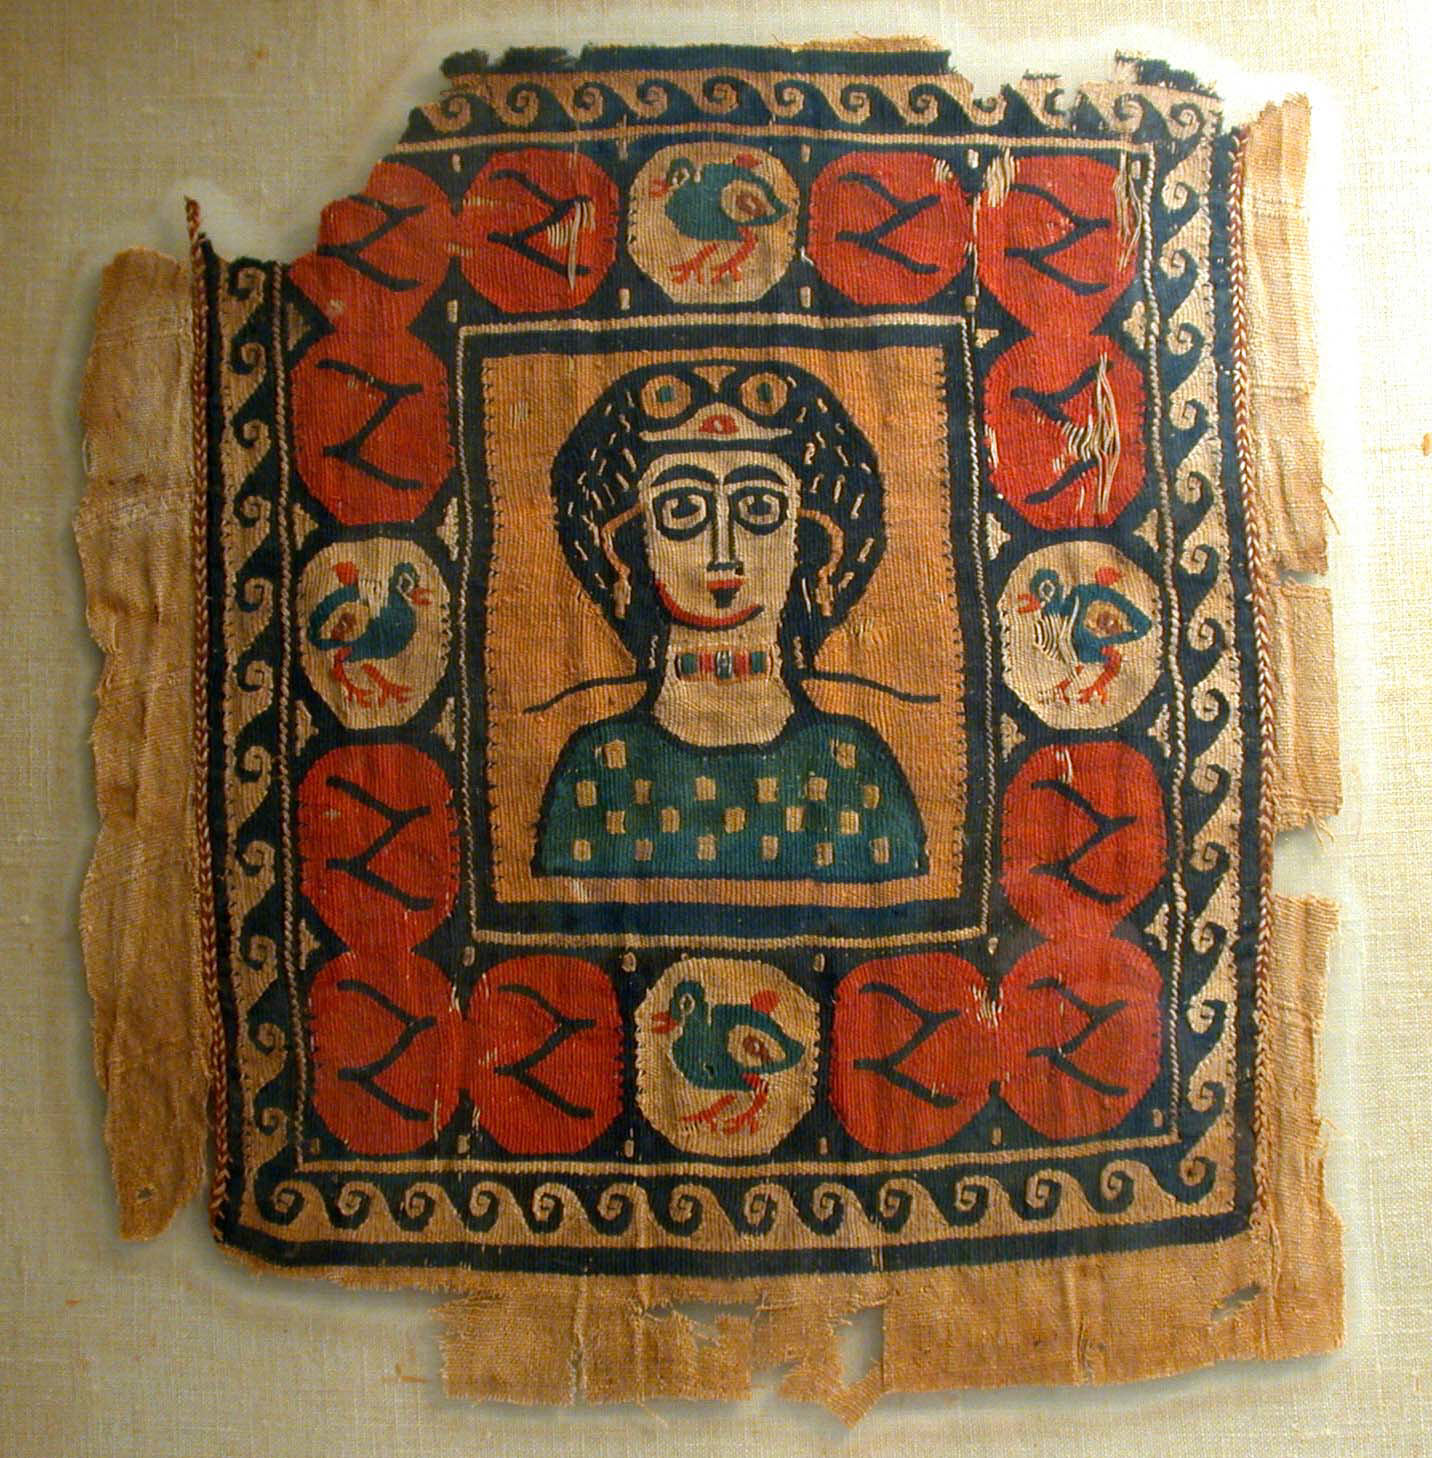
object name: textile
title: Portrait of a Lady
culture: byzantine or roman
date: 401-600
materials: linen, wool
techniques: polychrome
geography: egypt